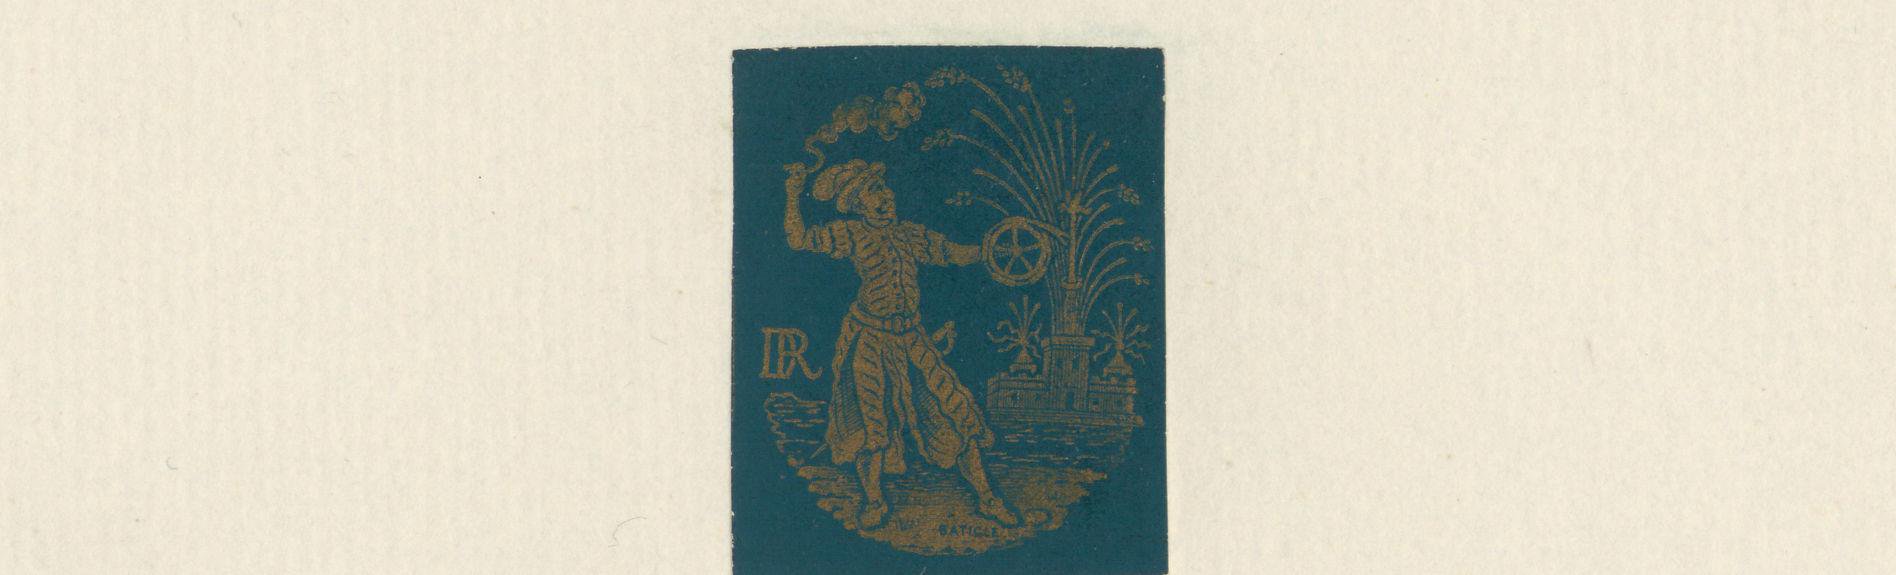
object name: bookplate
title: Ex libris van DR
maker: Anonymous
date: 1850-1950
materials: paper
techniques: engraving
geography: italy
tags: standing figure, castle, historical costume, bonfire, fire-works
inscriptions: inscription: ‘Ruggieri’, collector's mark: Lugt 2760